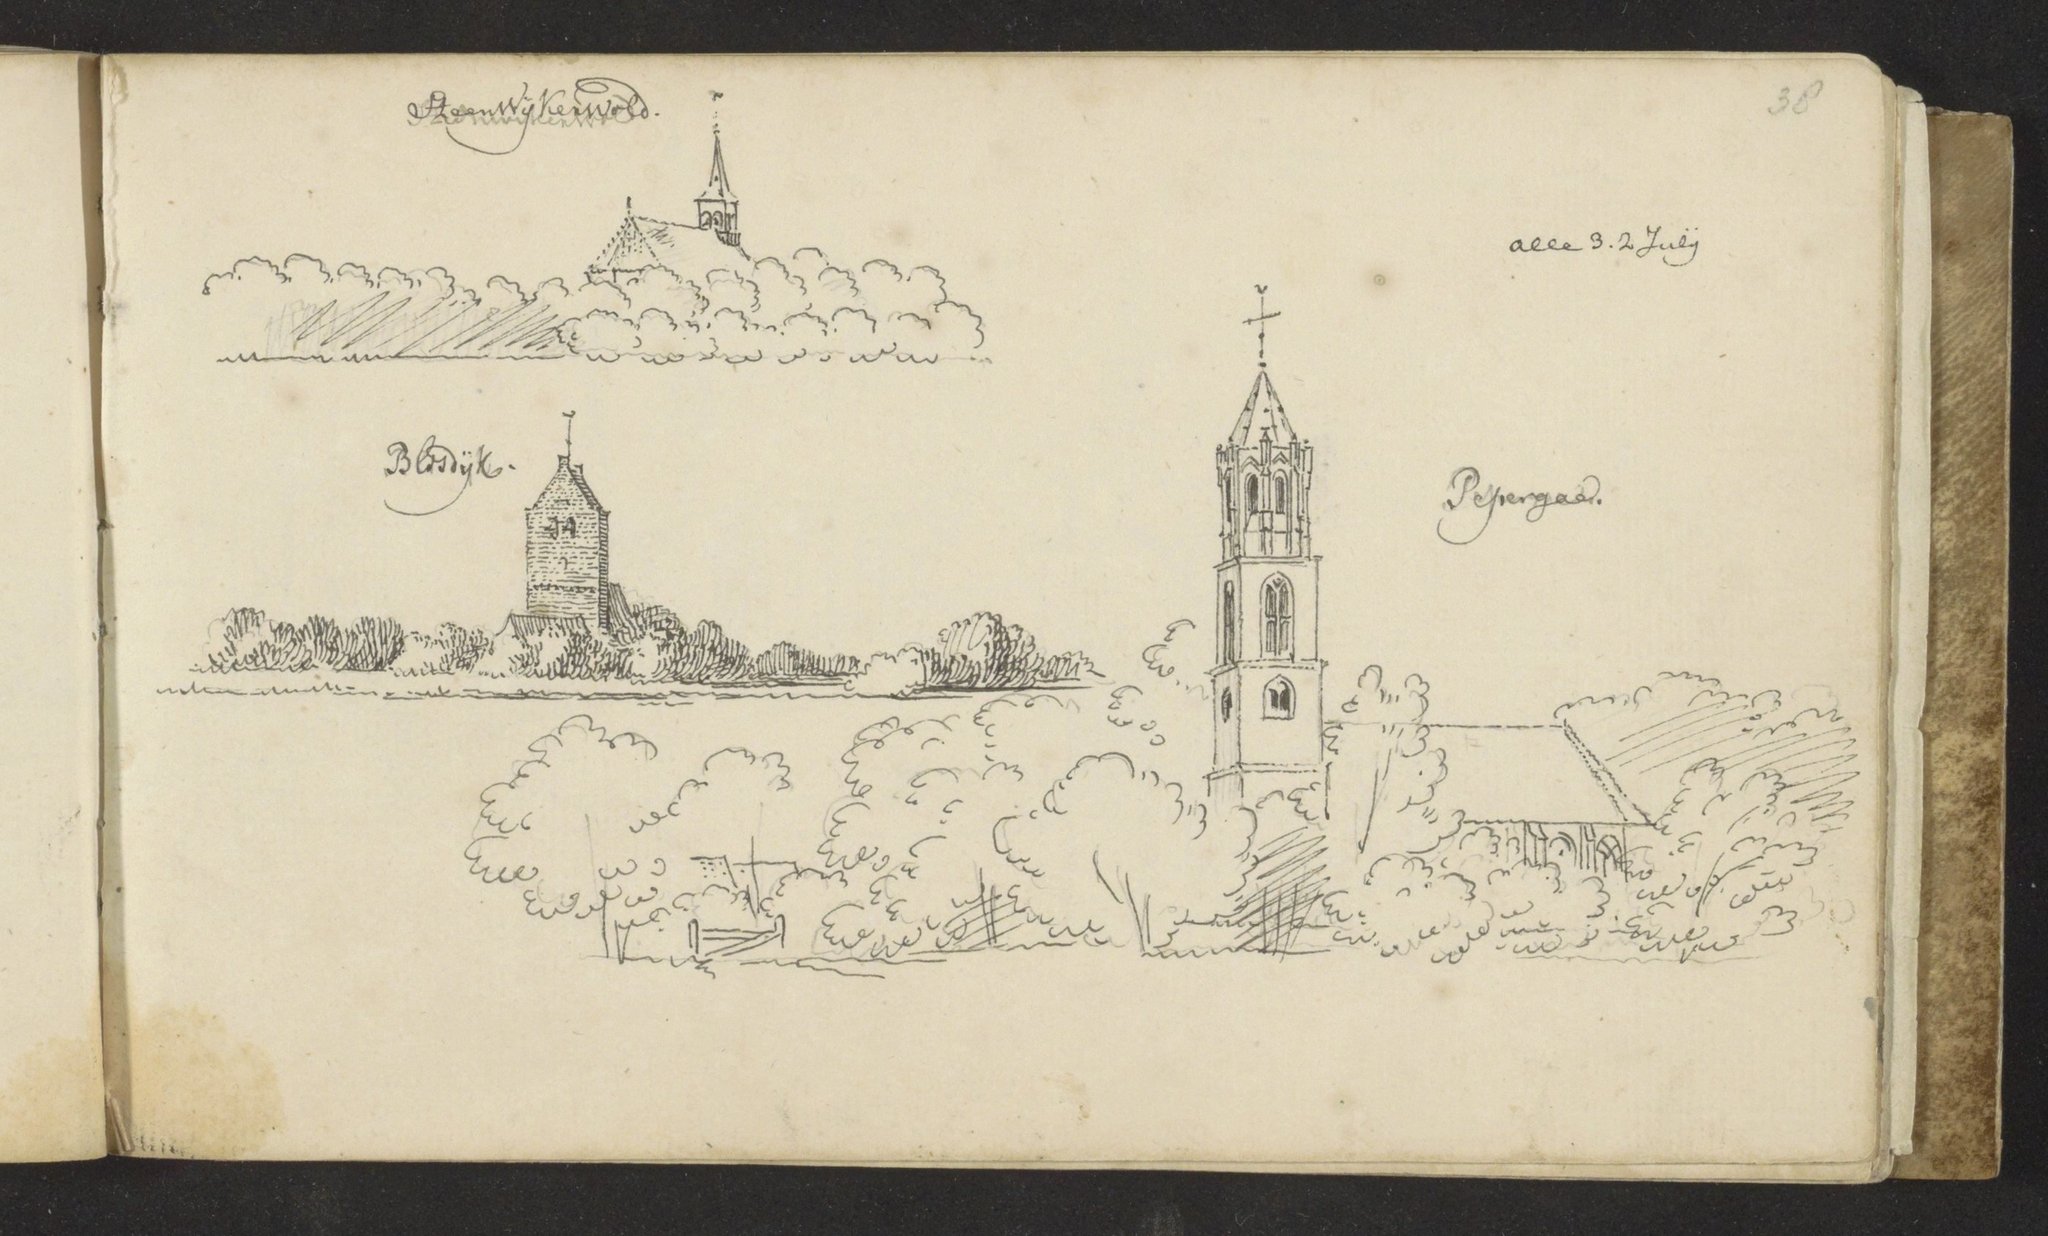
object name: sketchbook leaf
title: Gezichten op Steenwijkerwold, Blesdijke en Peperga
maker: abraham de haen (ii)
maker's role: draughtsman, print maker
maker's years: 1707-1748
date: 1732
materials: ink, paper, pencil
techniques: pen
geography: steenwijkerwold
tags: prospect of village, silhouette of village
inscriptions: date and inscription: ‘Steenwijkerwold/ Blesdijk/ alle 3.2 Julij/ Pepergaa’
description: Blad 38 recto uit een schetsboek met 51 bladen.